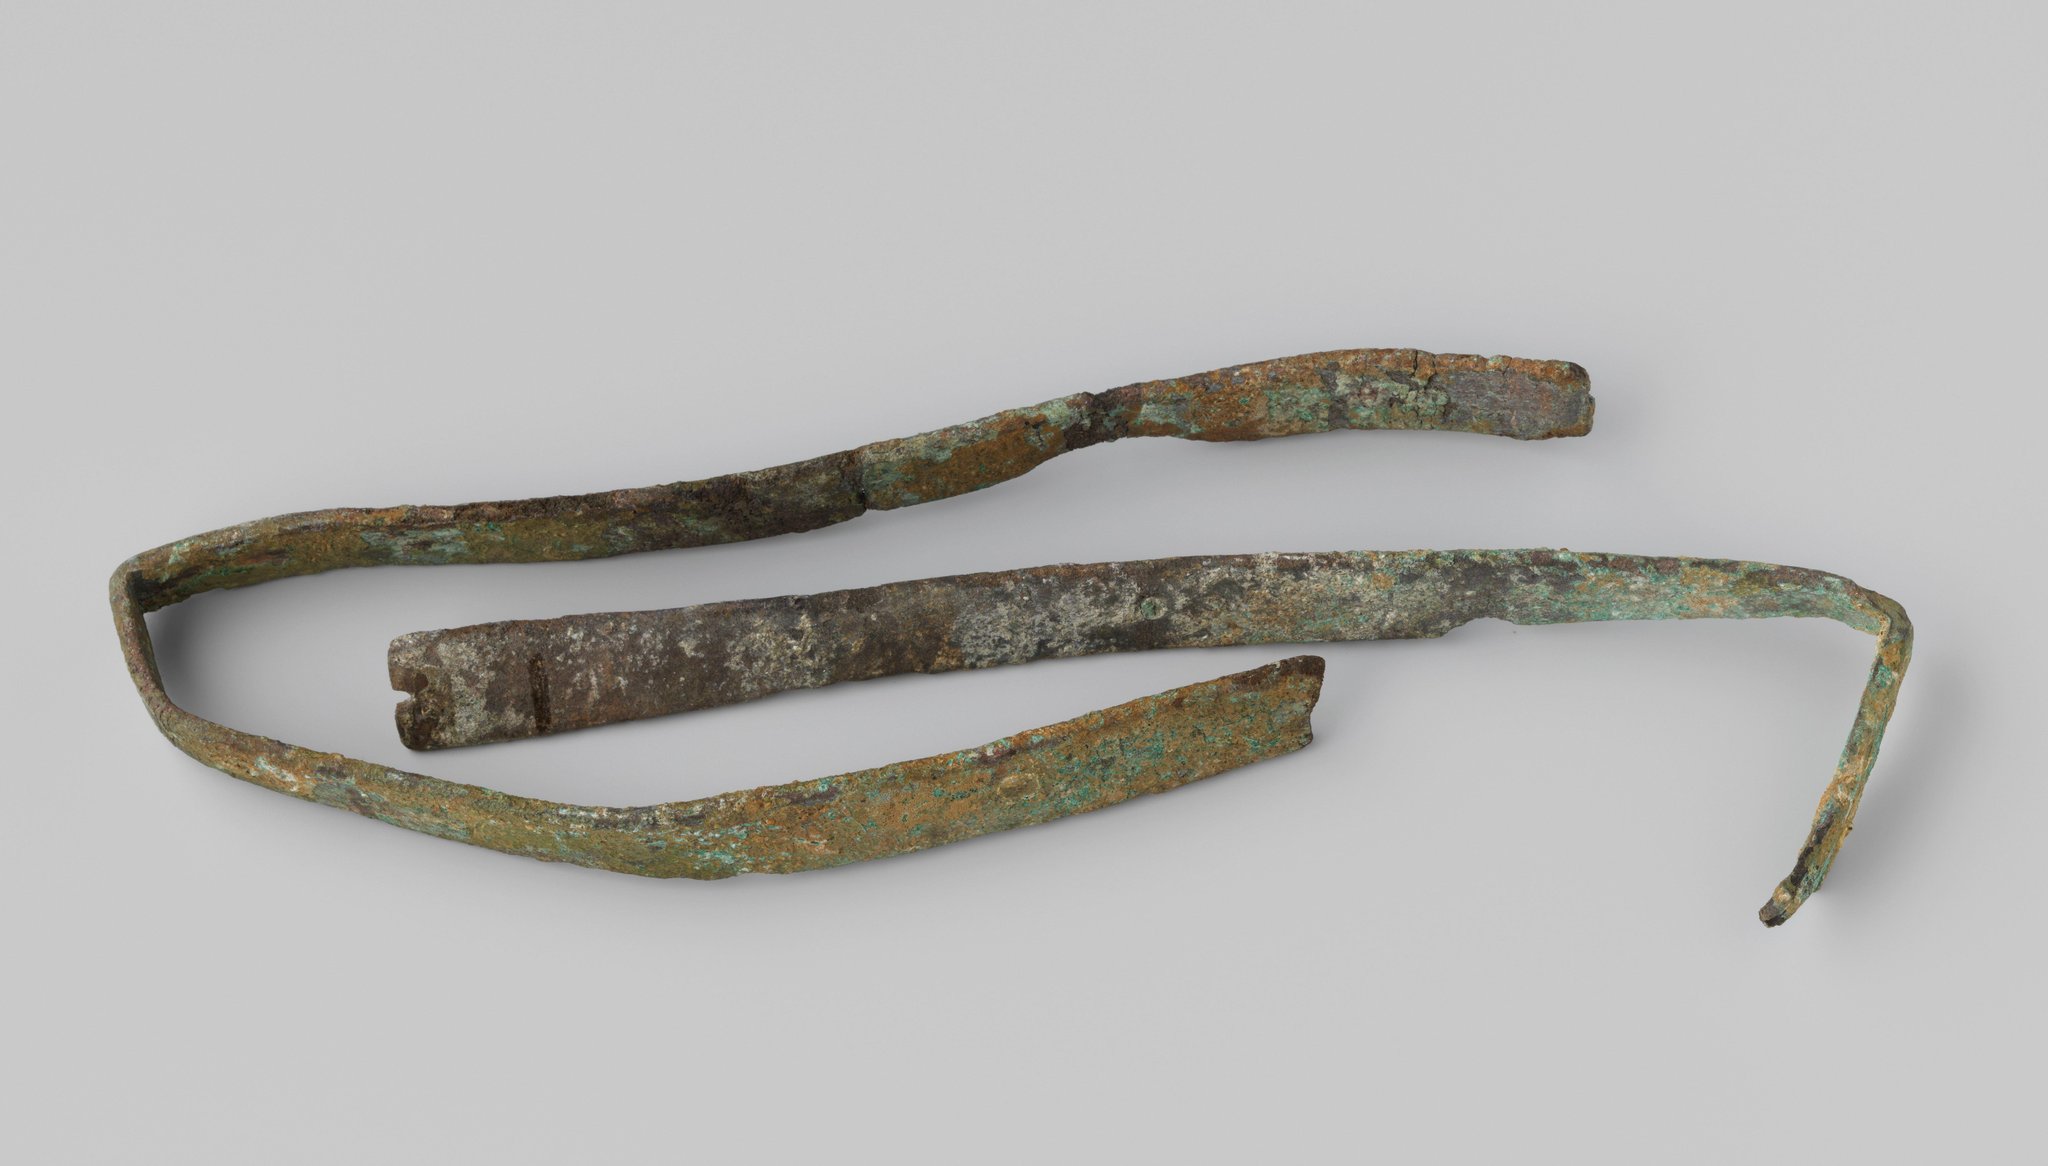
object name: part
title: Onderdelen of hulpstukken afkomstig uit het wrak van de Oost-Indiëvaarder Hollandia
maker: Anonymous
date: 1700-1743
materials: copper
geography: netherlands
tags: verenigde oostindische compagnie, hollandia (schip)